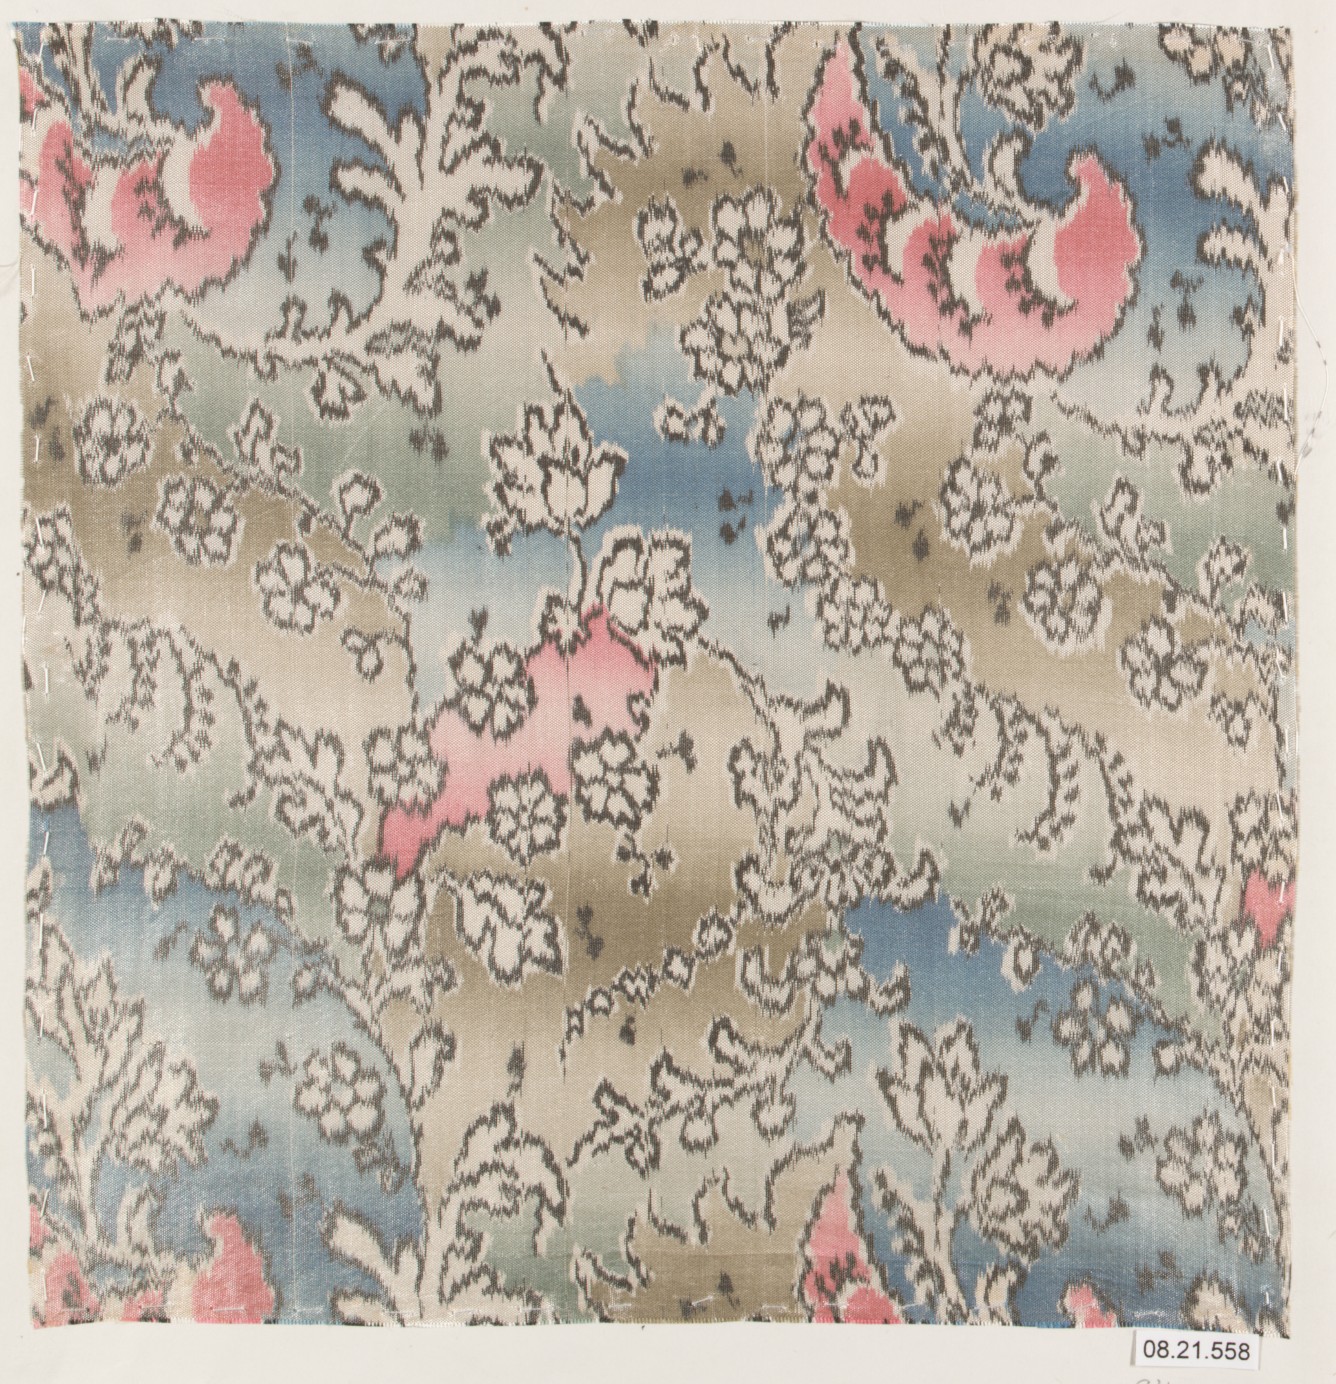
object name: textile sample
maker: Anonymous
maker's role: designer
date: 1900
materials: silk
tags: flowers